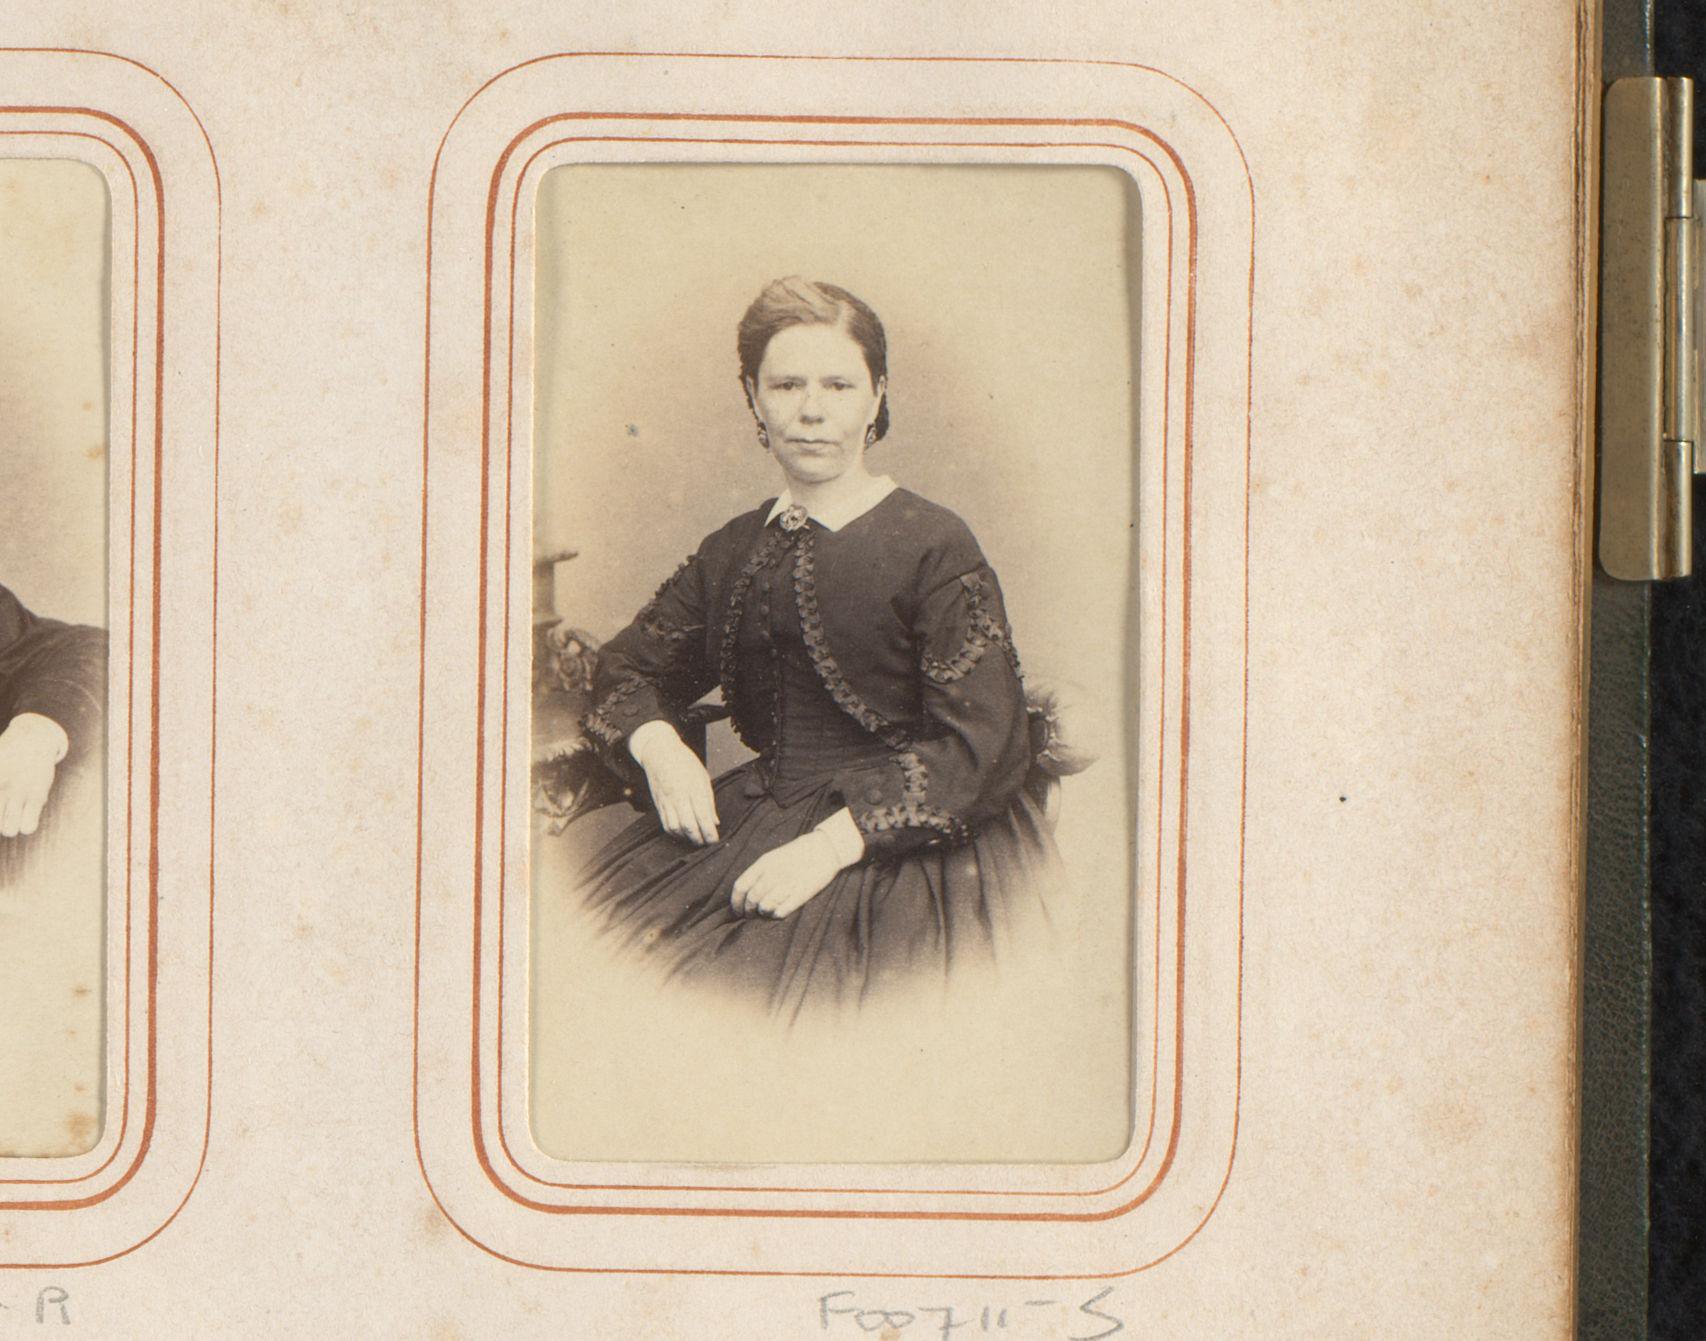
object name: photograph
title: Portret van een zittende vrouw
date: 1866-1870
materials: cardboard, photographic support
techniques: albumen print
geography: rotterdam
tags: historical persons - bb - woman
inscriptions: inscription: ‘C. Janssens & E. Rademacher/ Rotterdam/ Nieuwe Veemarkt/ No 341’